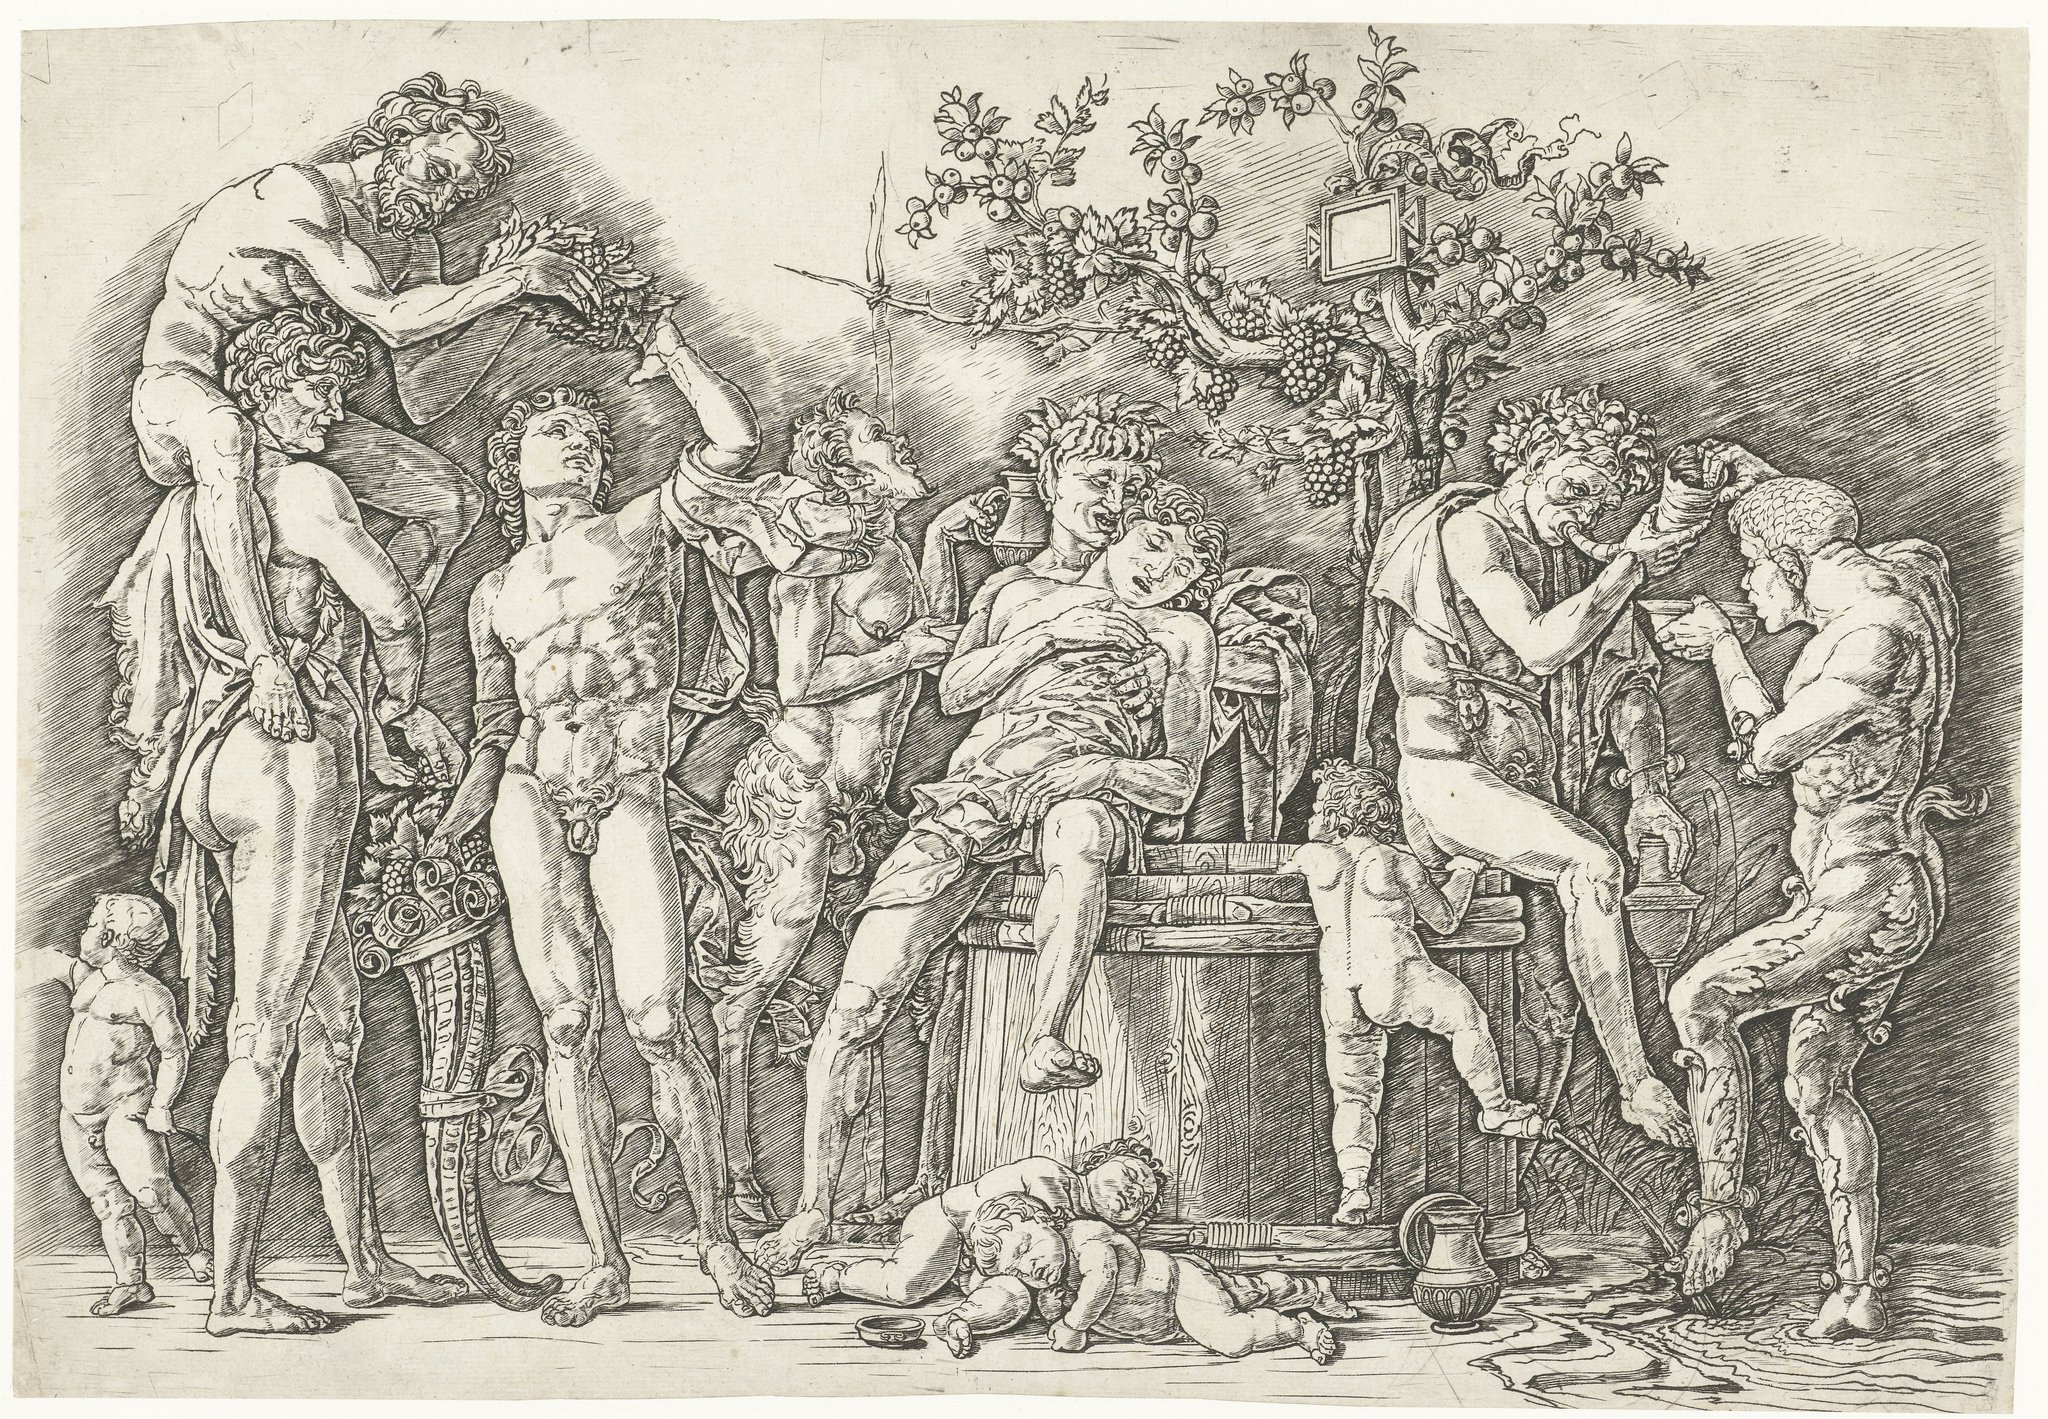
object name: print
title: Bacchanaal met satyrs en bacchanten bij wijnpers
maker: andrea mantegna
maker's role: print maker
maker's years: 1431-1506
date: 1473-1477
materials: paper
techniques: engraving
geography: italy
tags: thiasos, i.e. bacchus' revel-rout, bacchanal without bacchus, wine-press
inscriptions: collector's mark: Lugt 240